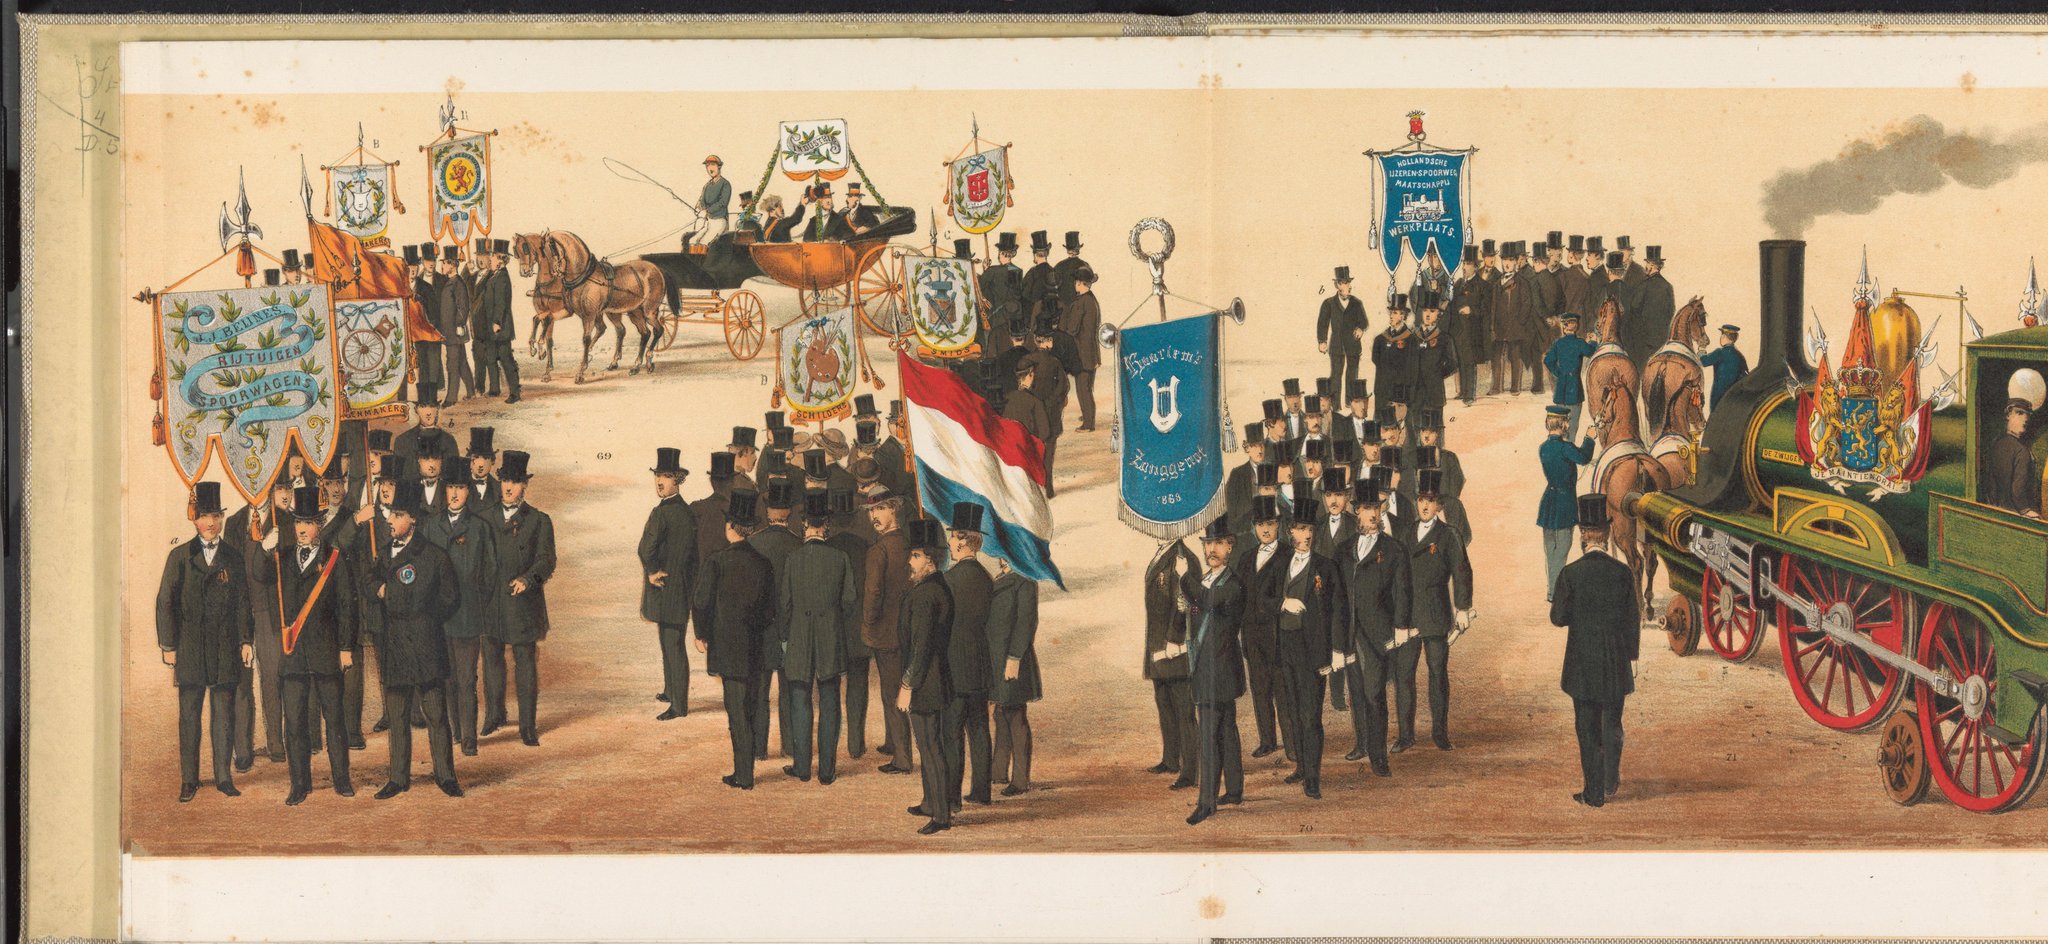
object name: print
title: Optocht gehouden te Haarlem, den 1en April 1872.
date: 1872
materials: paper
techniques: chromolithography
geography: haarlem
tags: festivities on events of national importance (+ parade, pageant, cavalcade ~ festive activities), costumes used in pageants, steam locomotive, haarlem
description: Feestelijke optocht gehouden te Haarlem tijdens de Aprilfeesten op 1 april 1872 ter gelegenheid van het 300-jarige onafhankelijkheid van Nederland. Rechts de stoomlocomotief "De Zwijger". Elfde plaat met de groepen genummerd 69-71. Onderdeel van de serie van twaalf aaneen geplakte bladen.